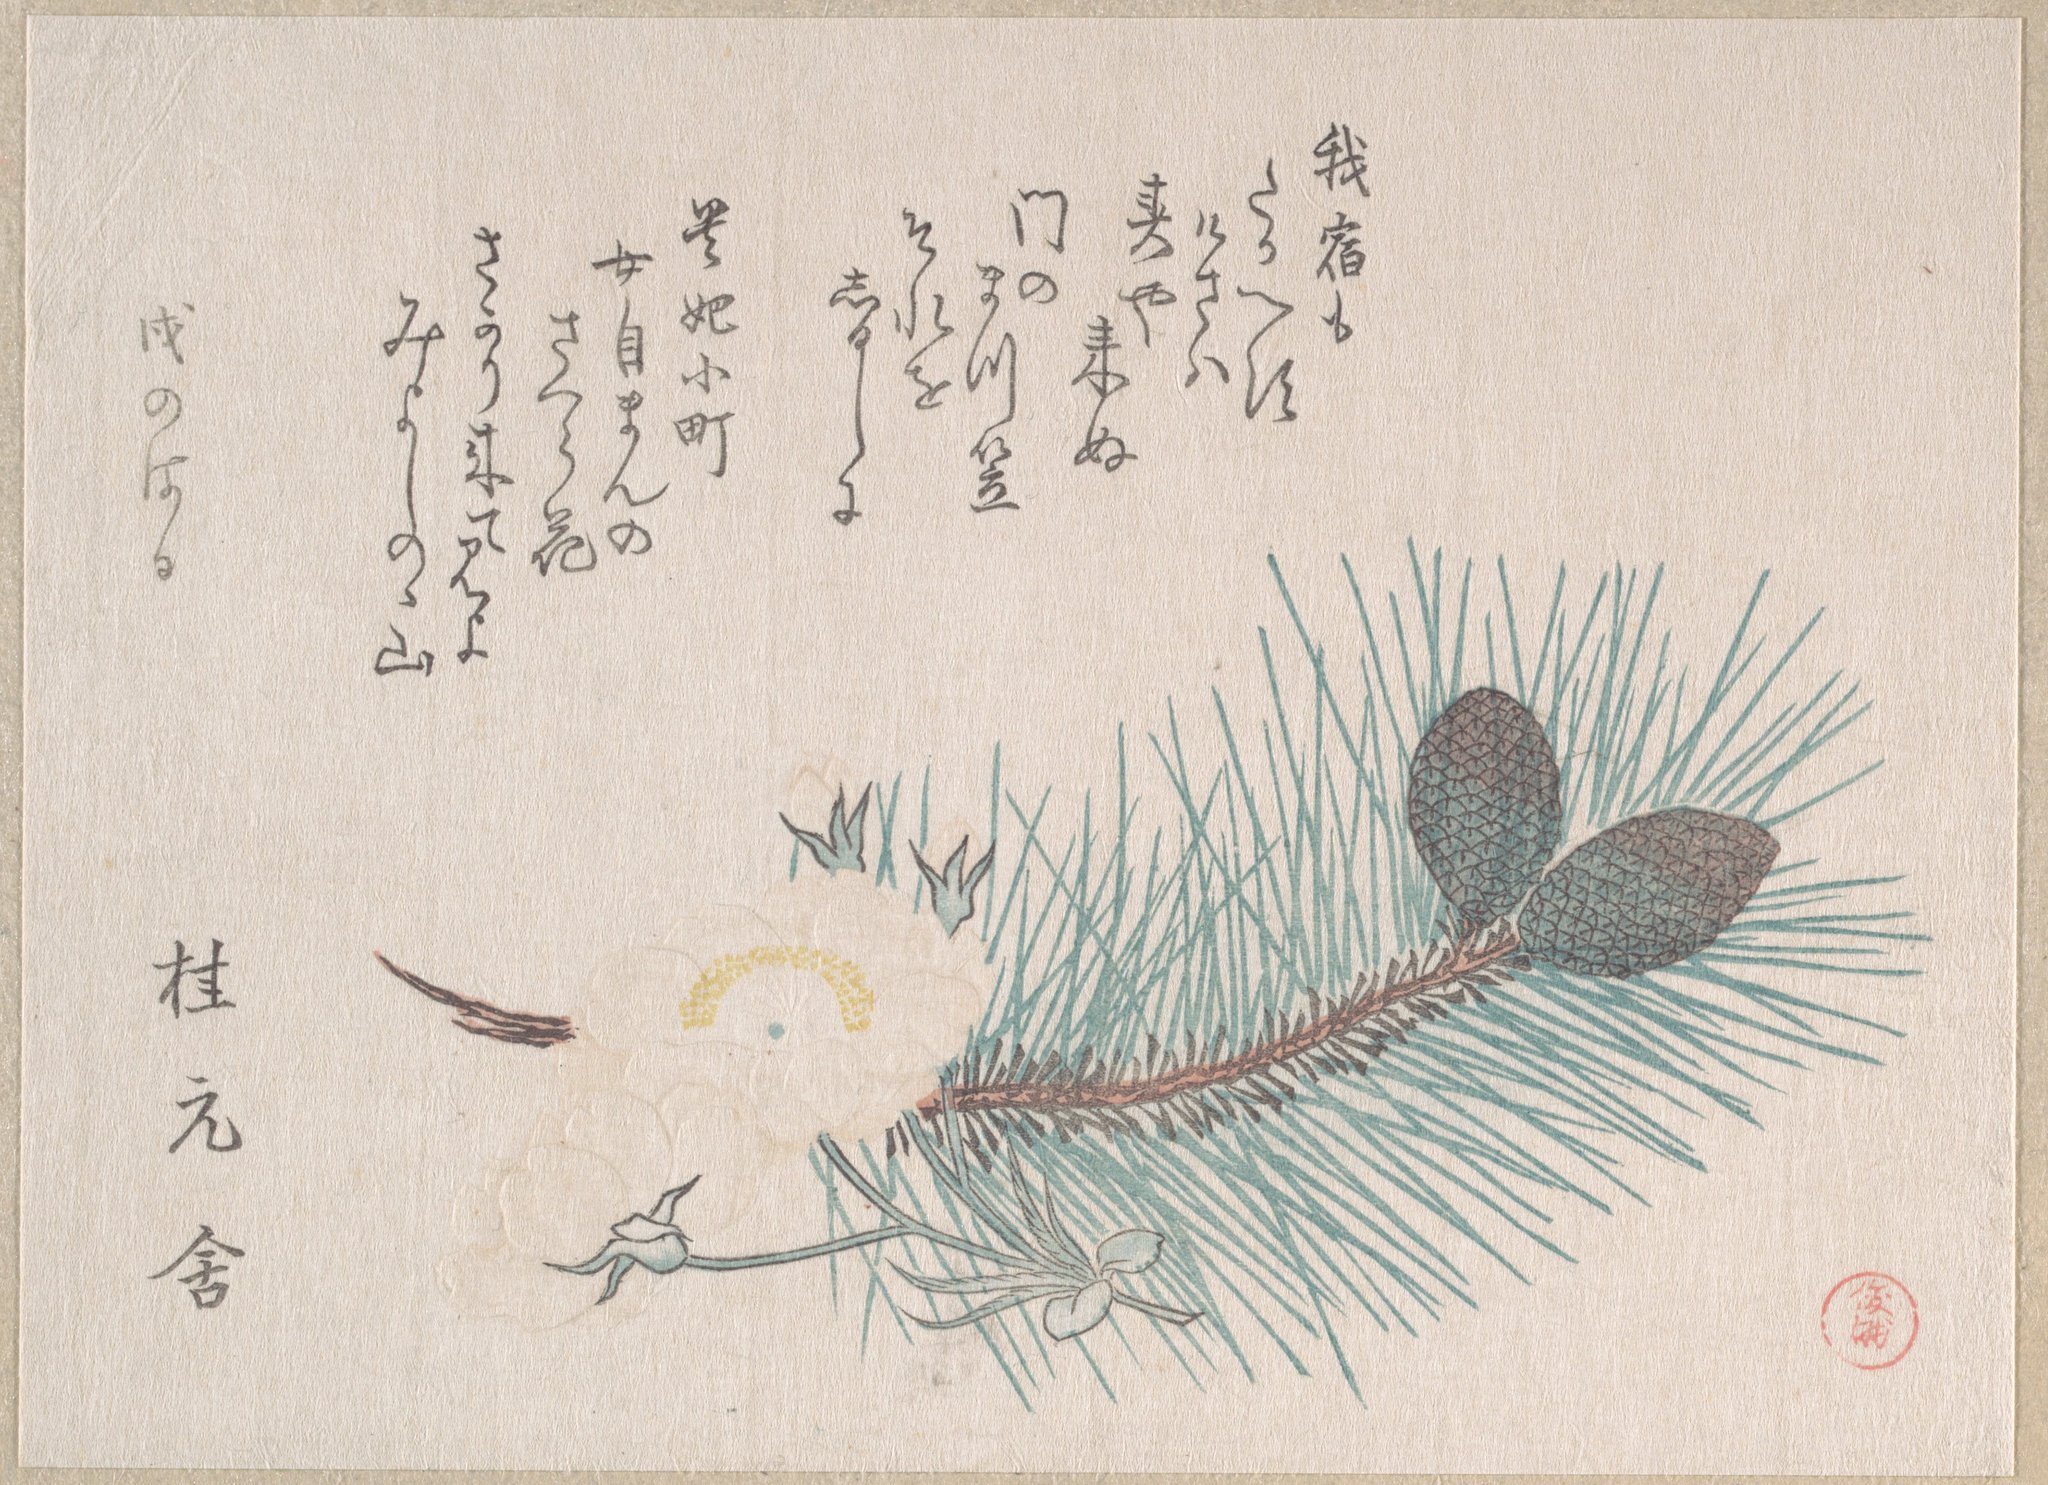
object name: print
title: Pines and Cherry Blossoms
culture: japanese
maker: kubo shunman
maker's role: artist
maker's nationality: japanese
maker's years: 1757-1820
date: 1814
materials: ink, paper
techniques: surimono, woodblock print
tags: flowers